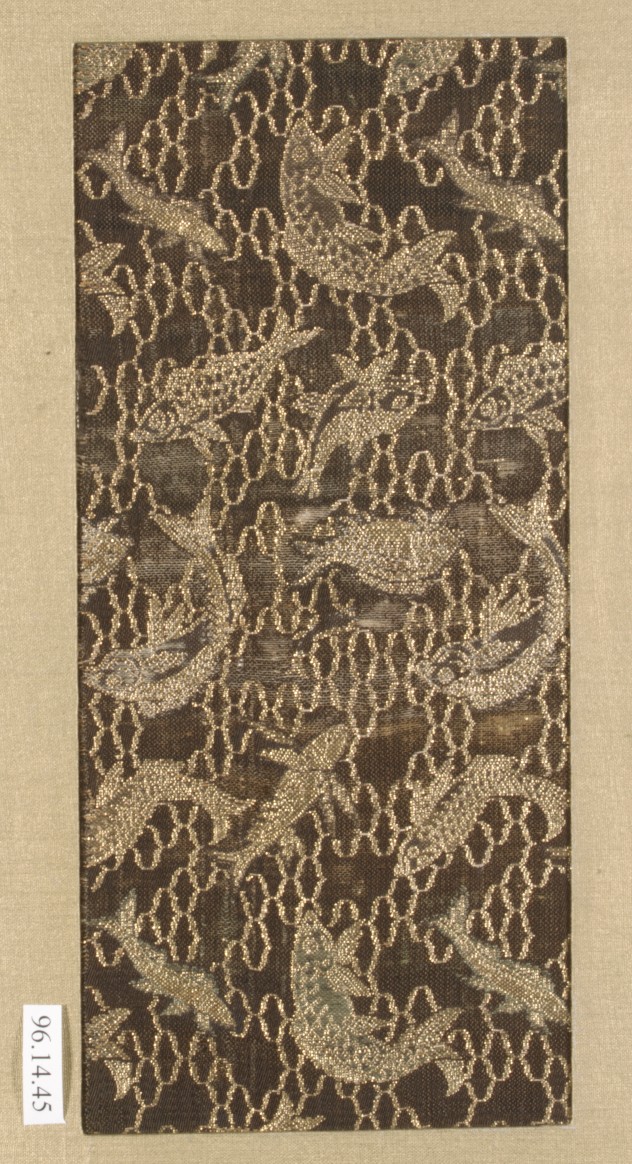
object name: piece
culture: japanese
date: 1701-1800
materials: metal thread, silk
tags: fish